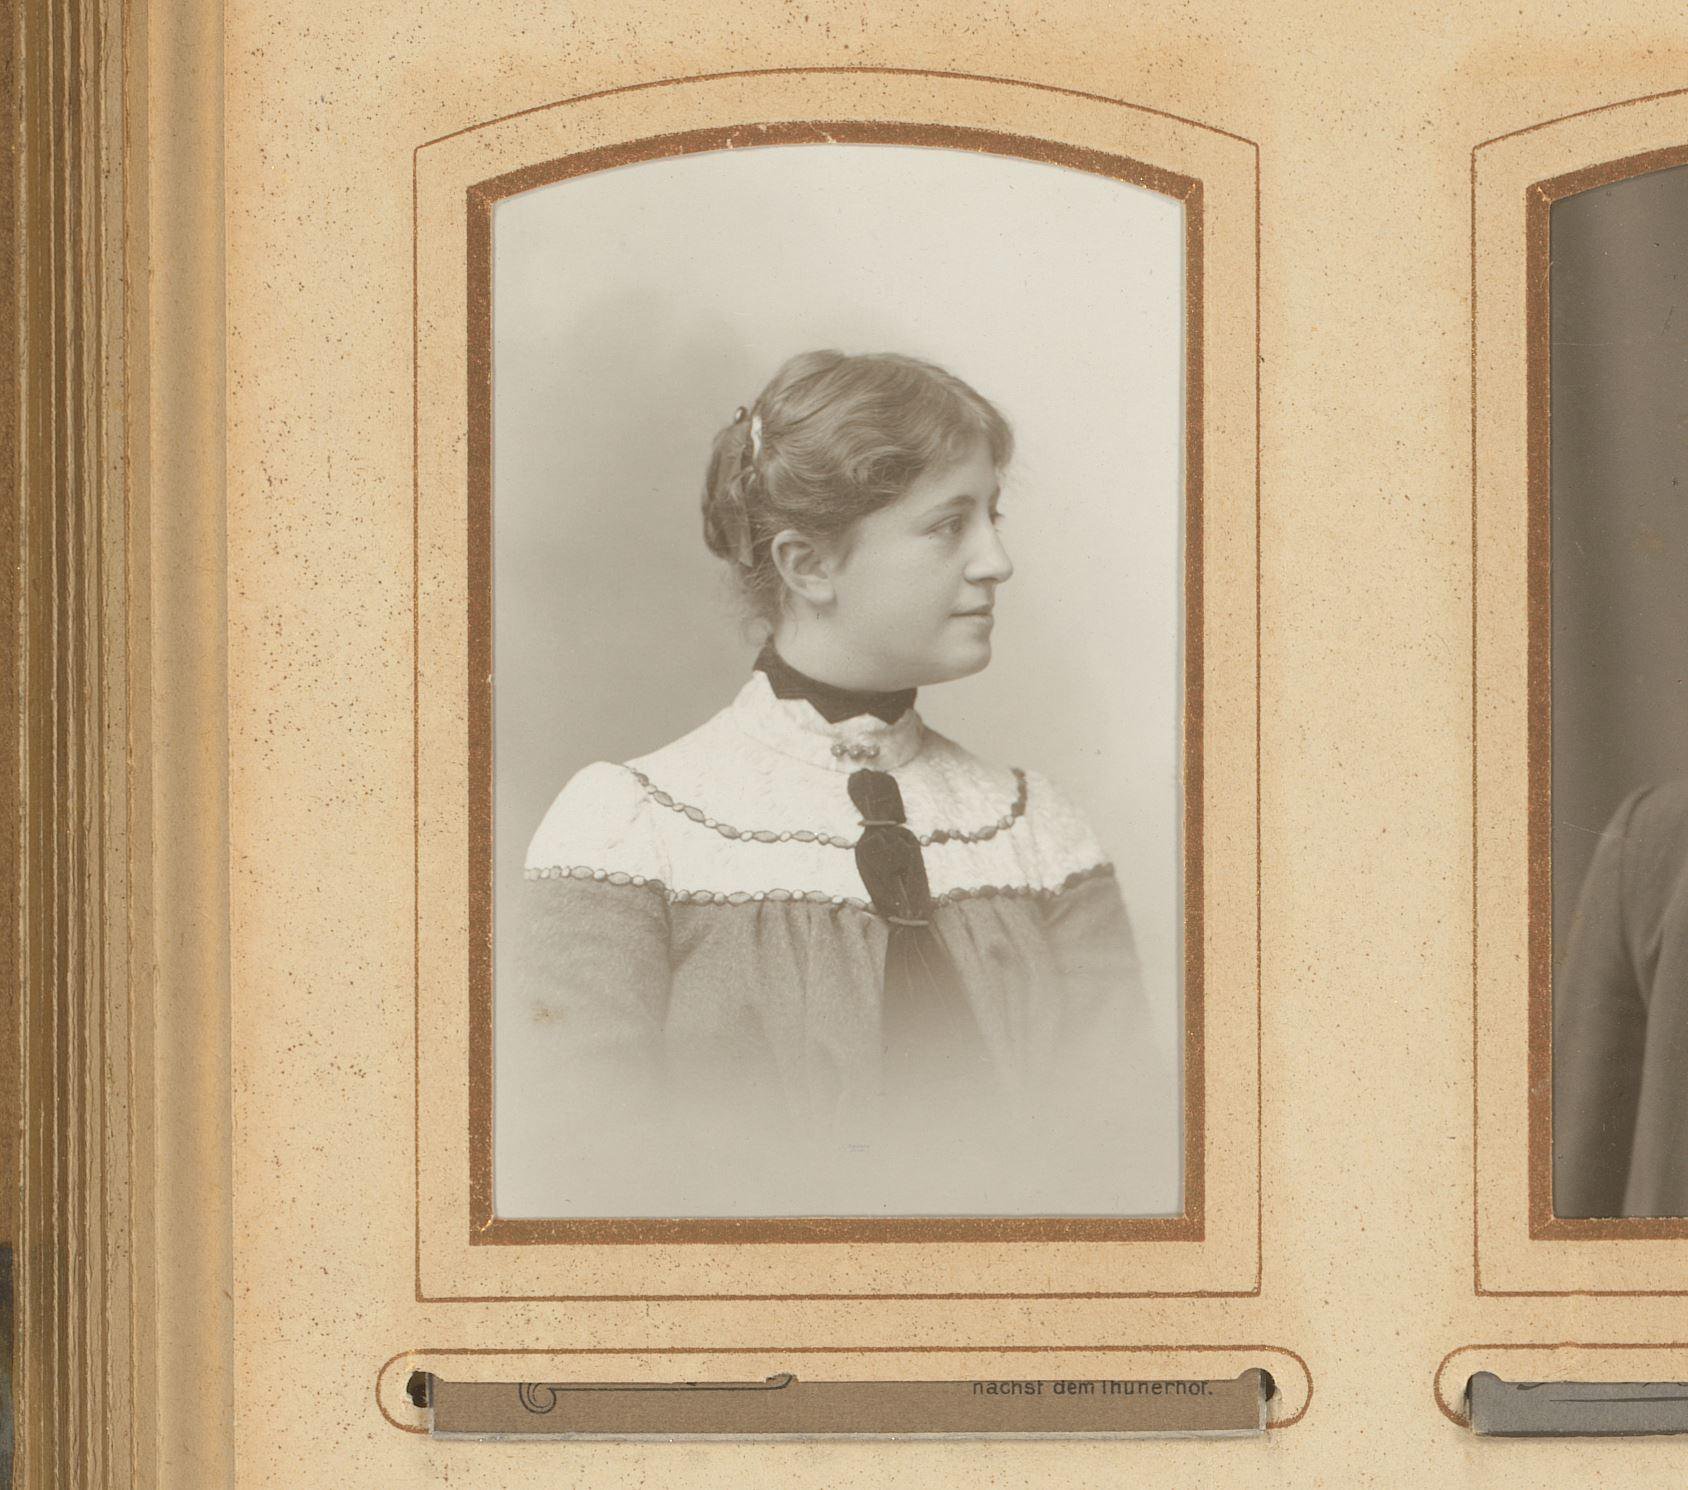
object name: carte de visite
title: Portret van een vrouw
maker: jean moeglé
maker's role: fotograaf, hofleverancier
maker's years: 1853-1938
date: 1899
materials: cardboard, photographic support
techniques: collodion silver print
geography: thun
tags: historical persons - bb - woman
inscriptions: inscription: ‘J. Moeglé Thun/ nächst dem Thunerhof’, inscription: ‘Thun/ Schweiz - Suisse/ nächst dm Thunerhof/ près du Grand hôtel/ Ehrendiplom/ Thun 1899 (...)’